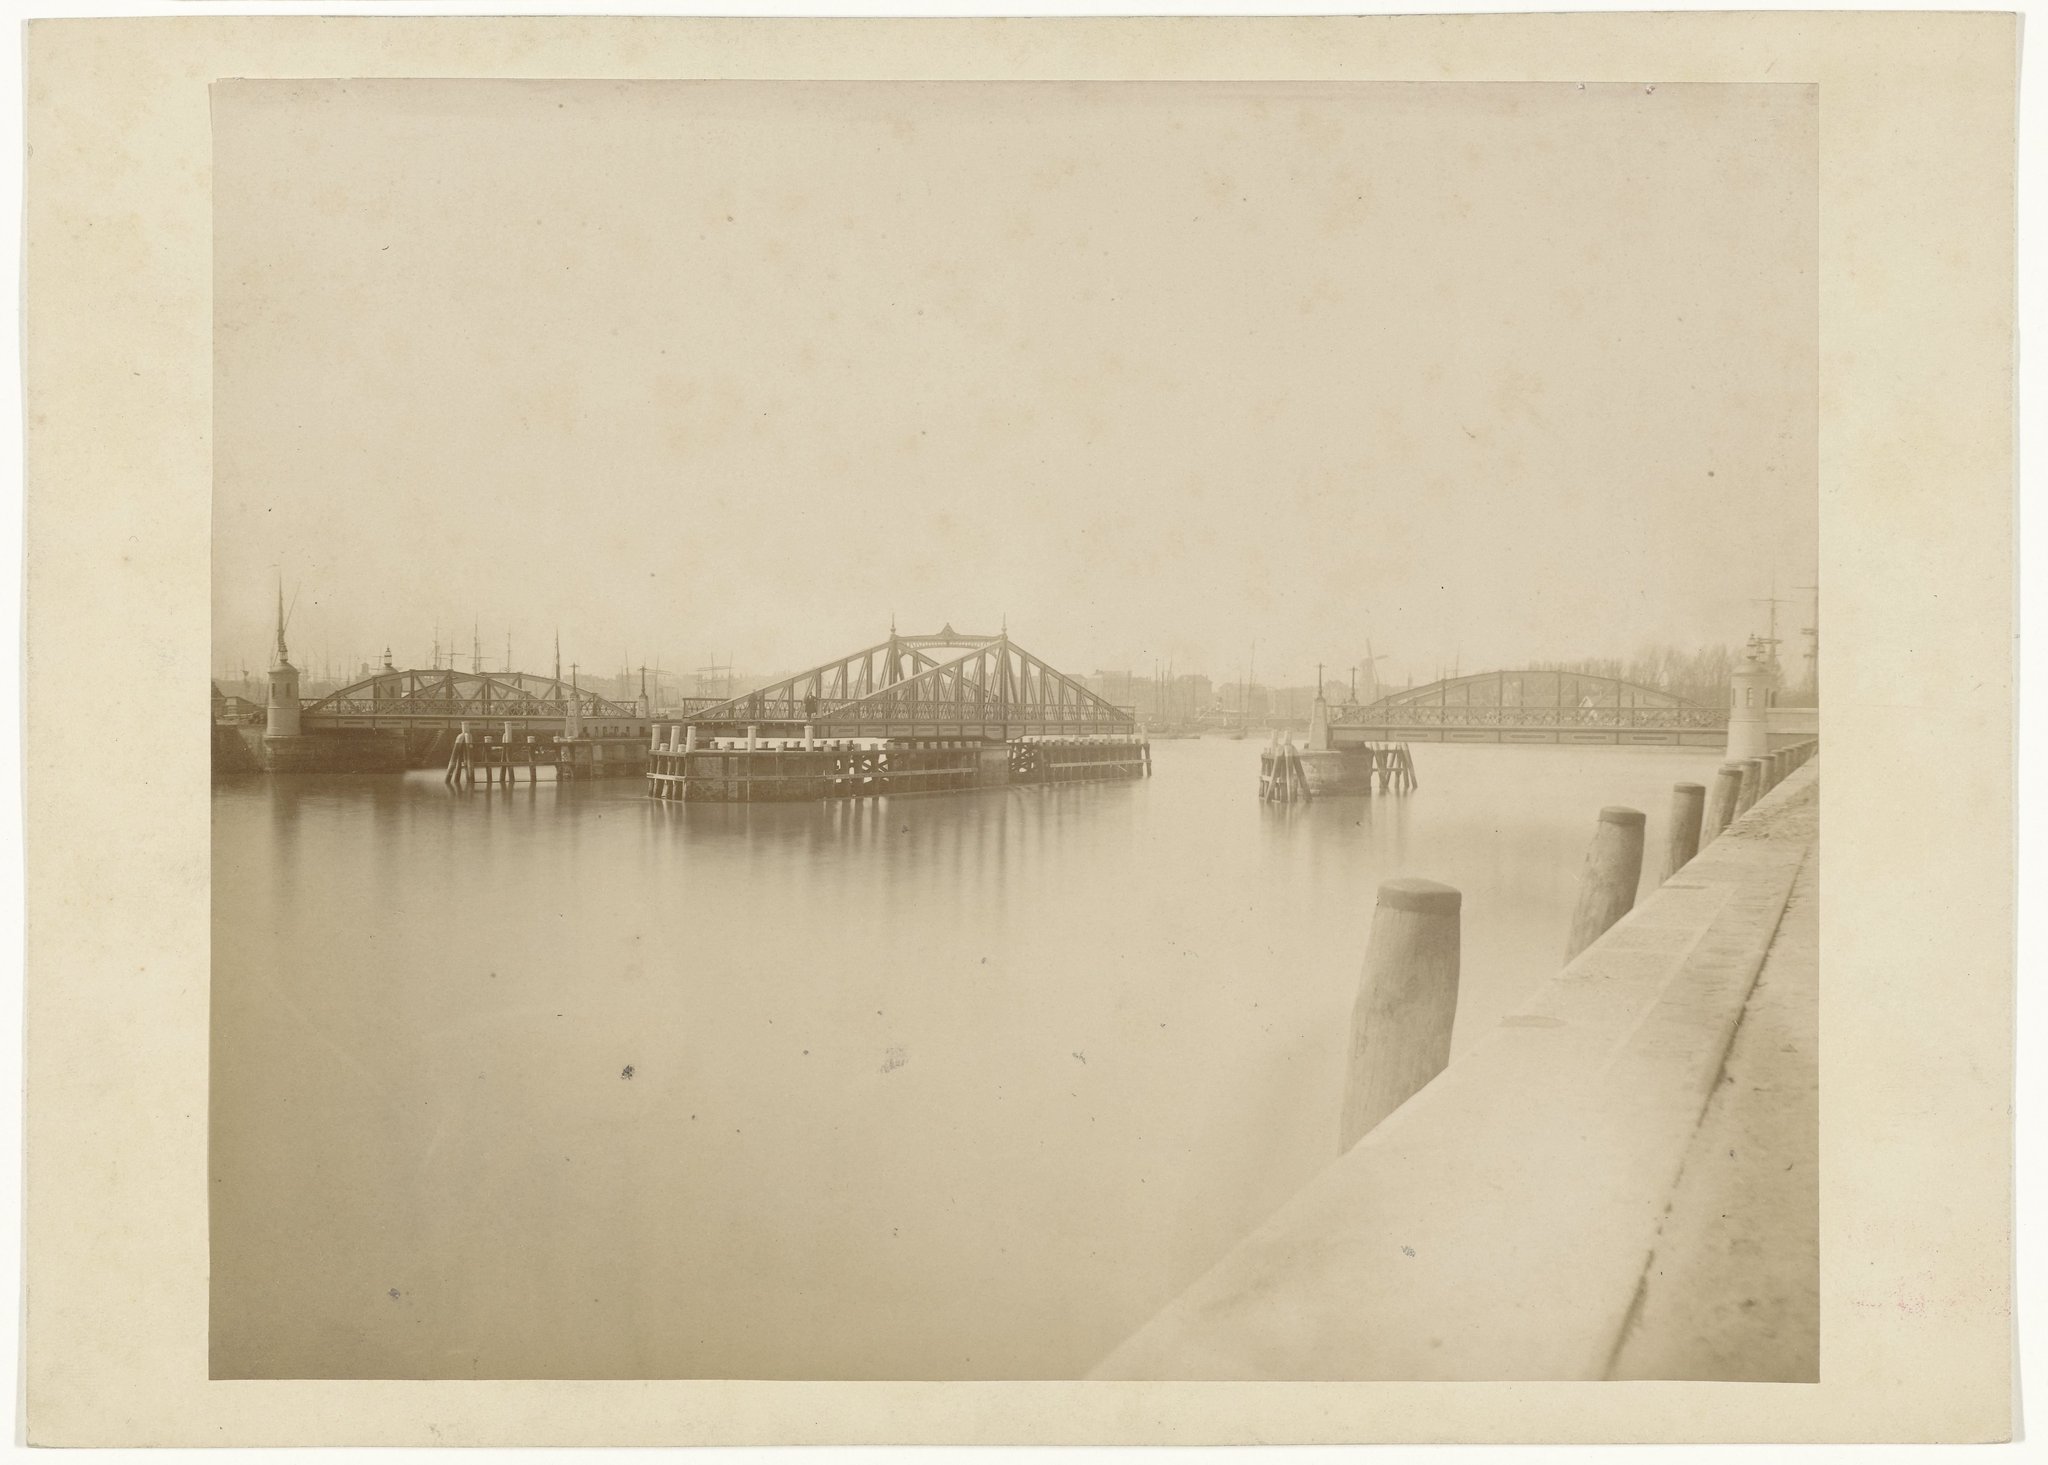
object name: photograph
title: Oude Koninginnebrug over de Spoorweghaven in Rotterdam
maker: Anonymous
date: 1870-1890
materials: paper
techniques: albumen print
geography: rotterdam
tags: bridge in city across river, canal, etc.